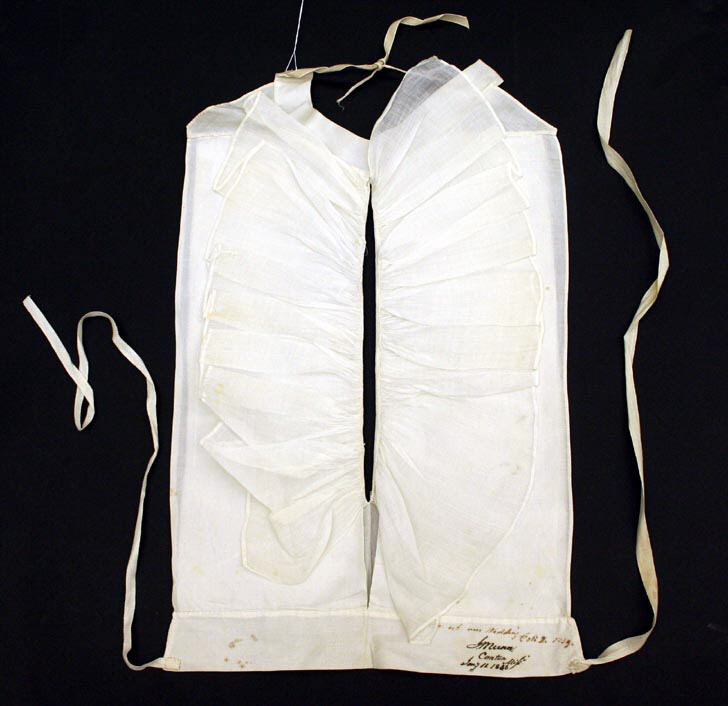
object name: dickey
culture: american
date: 1839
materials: linen